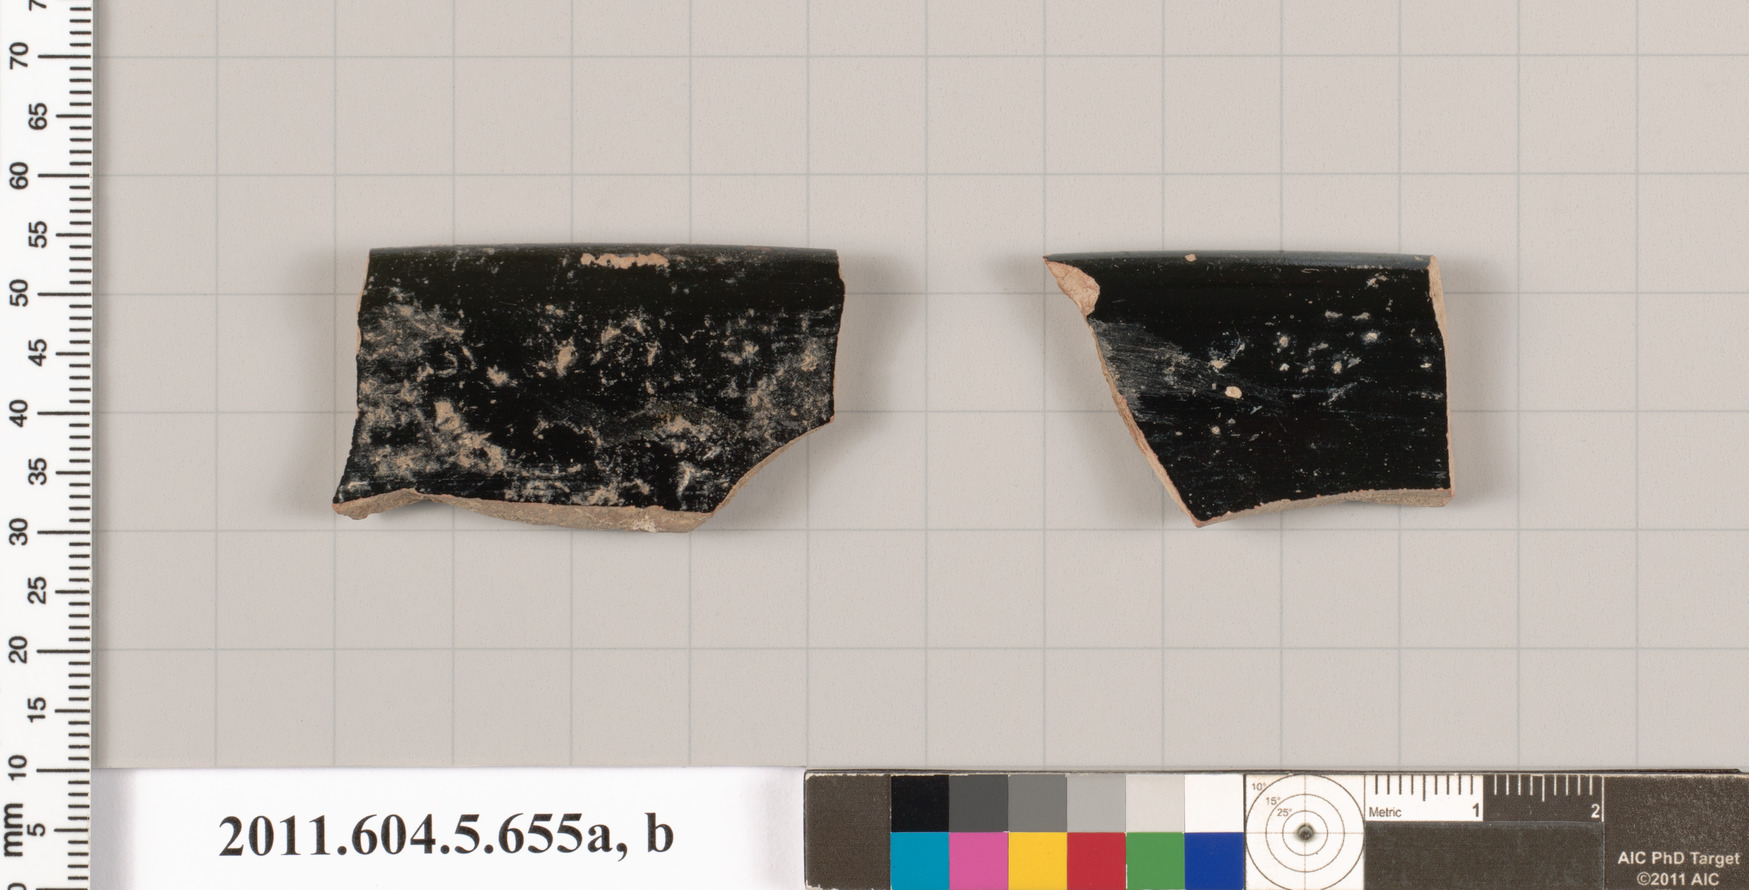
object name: kylix fragment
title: Terracotta rim fragments of kylikes (drinking cups)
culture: greek, attic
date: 600-401 BCE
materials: terracotta